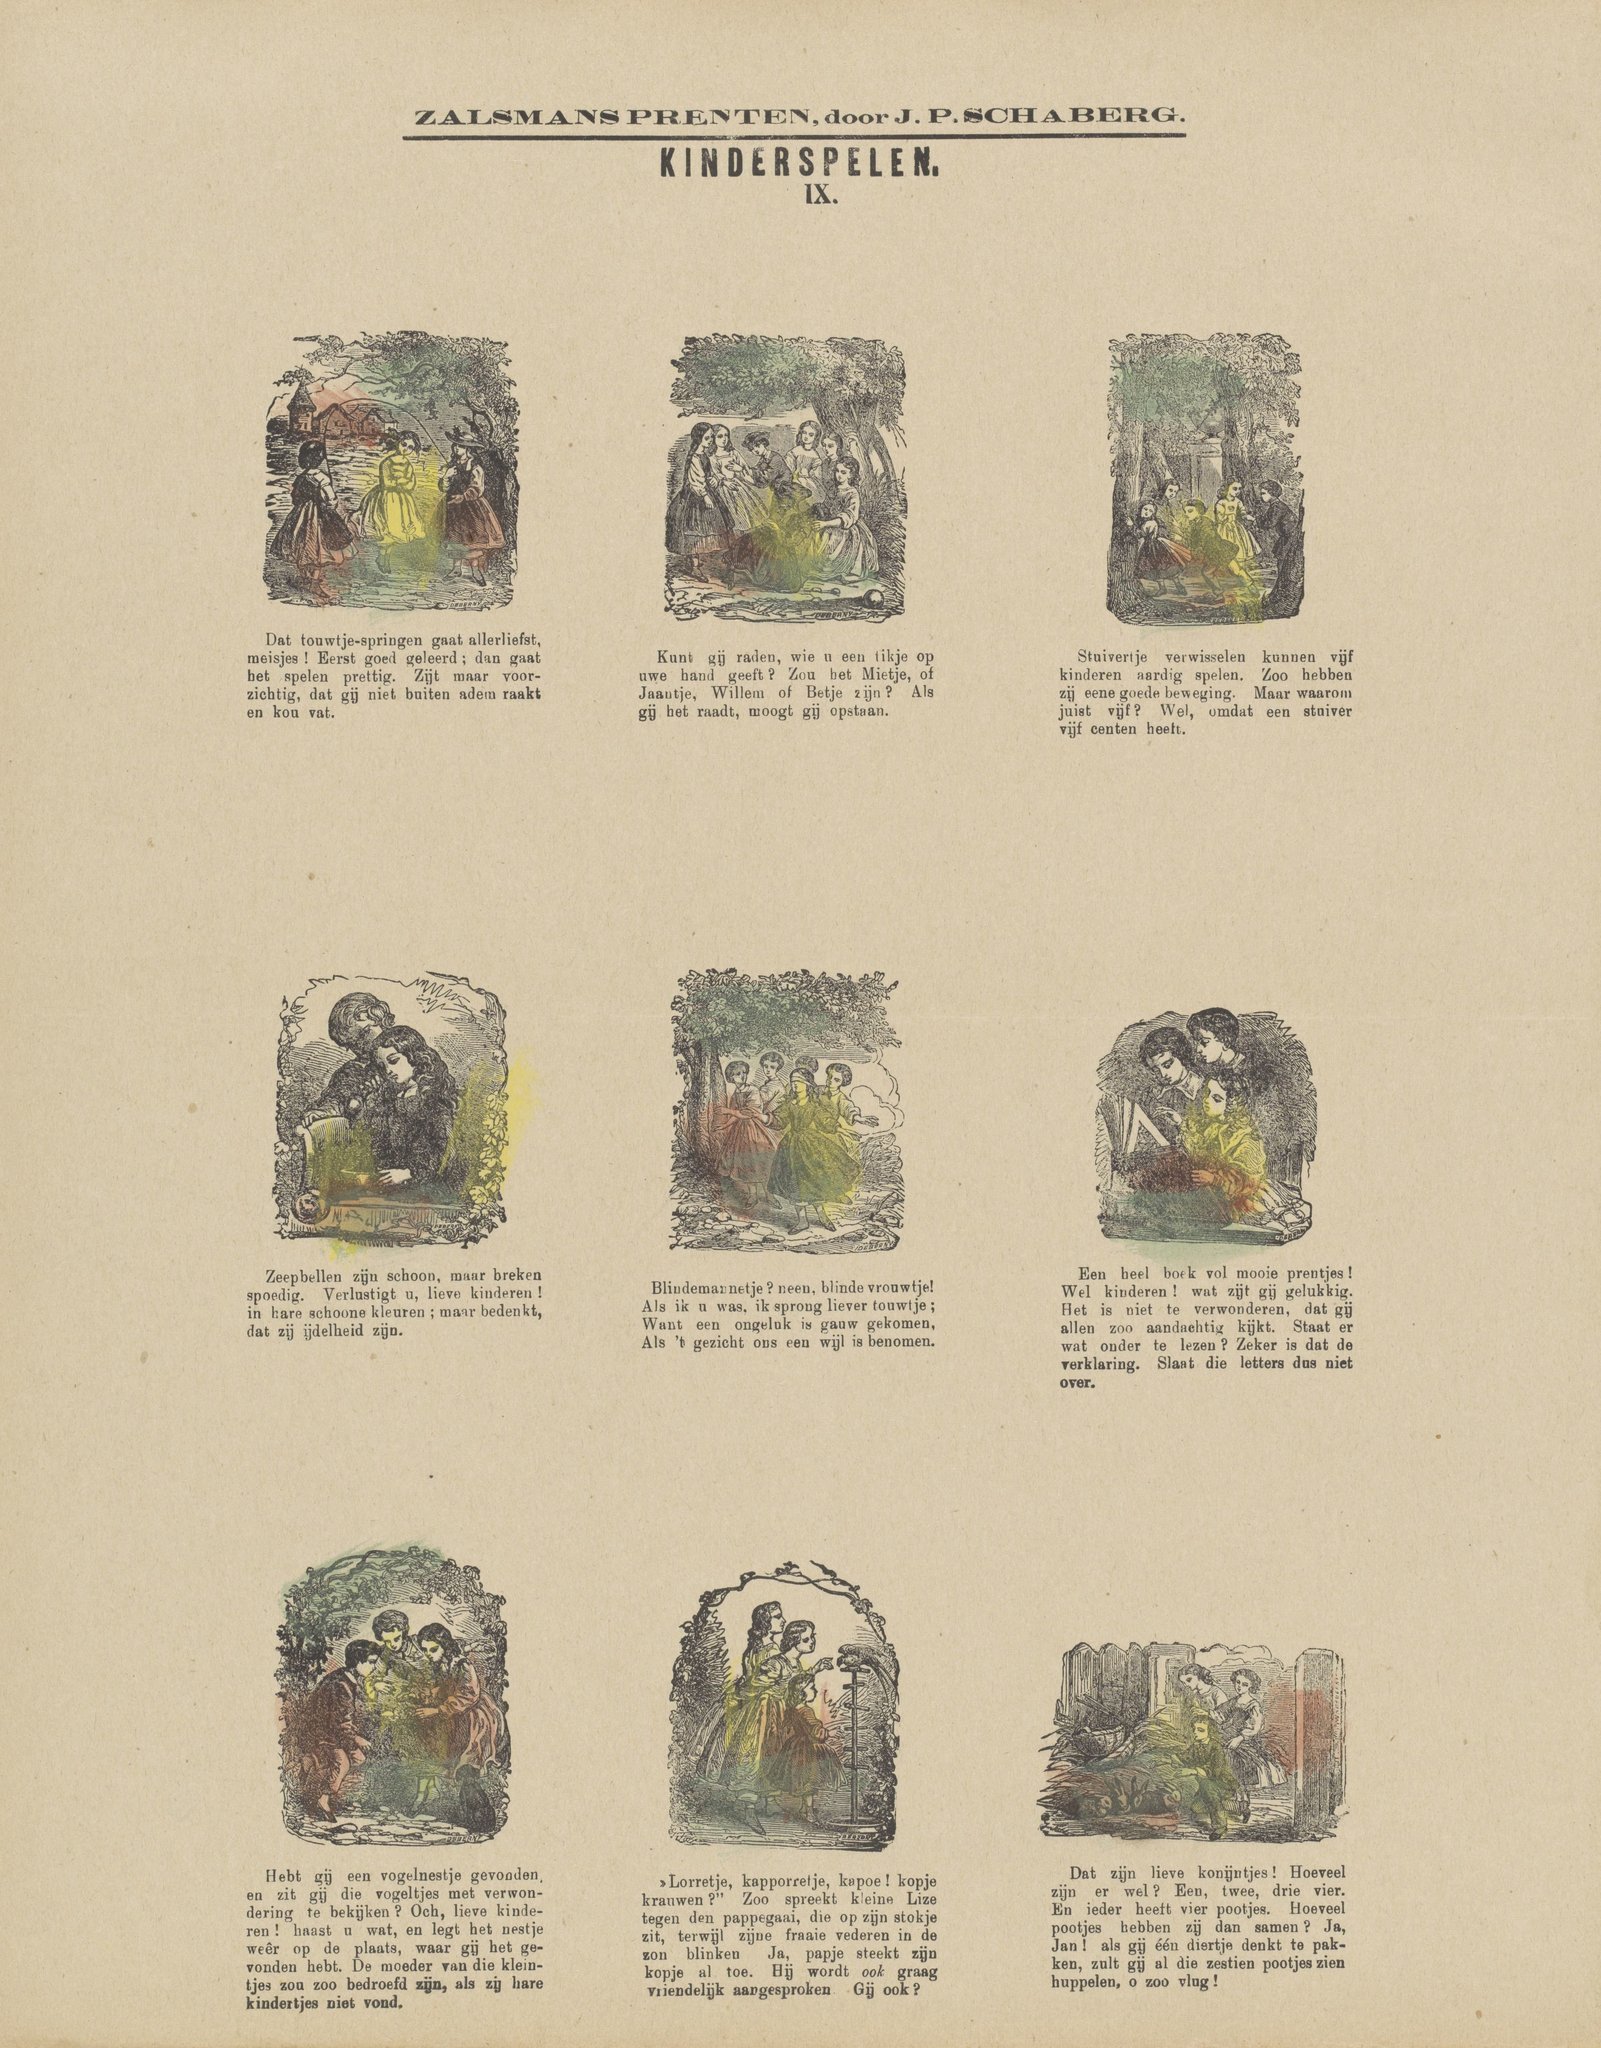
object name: popular print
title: Zalmans prenten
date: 1869-1882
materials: paper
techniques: colour, letterpress printing, engraving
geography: europe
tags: children's games and plays, blind-man's buff, child, child playing with animals, jumping-rope games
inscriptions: collector's mark: Lugt 2760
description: Blad met 9 voorstellingen van kinderspelen en bezigheden, zoals touwtjespringen, blindemannetje en met dieren spelen. Onder elke voorstelling een onderschrift. Genummerd midden boven: IX.